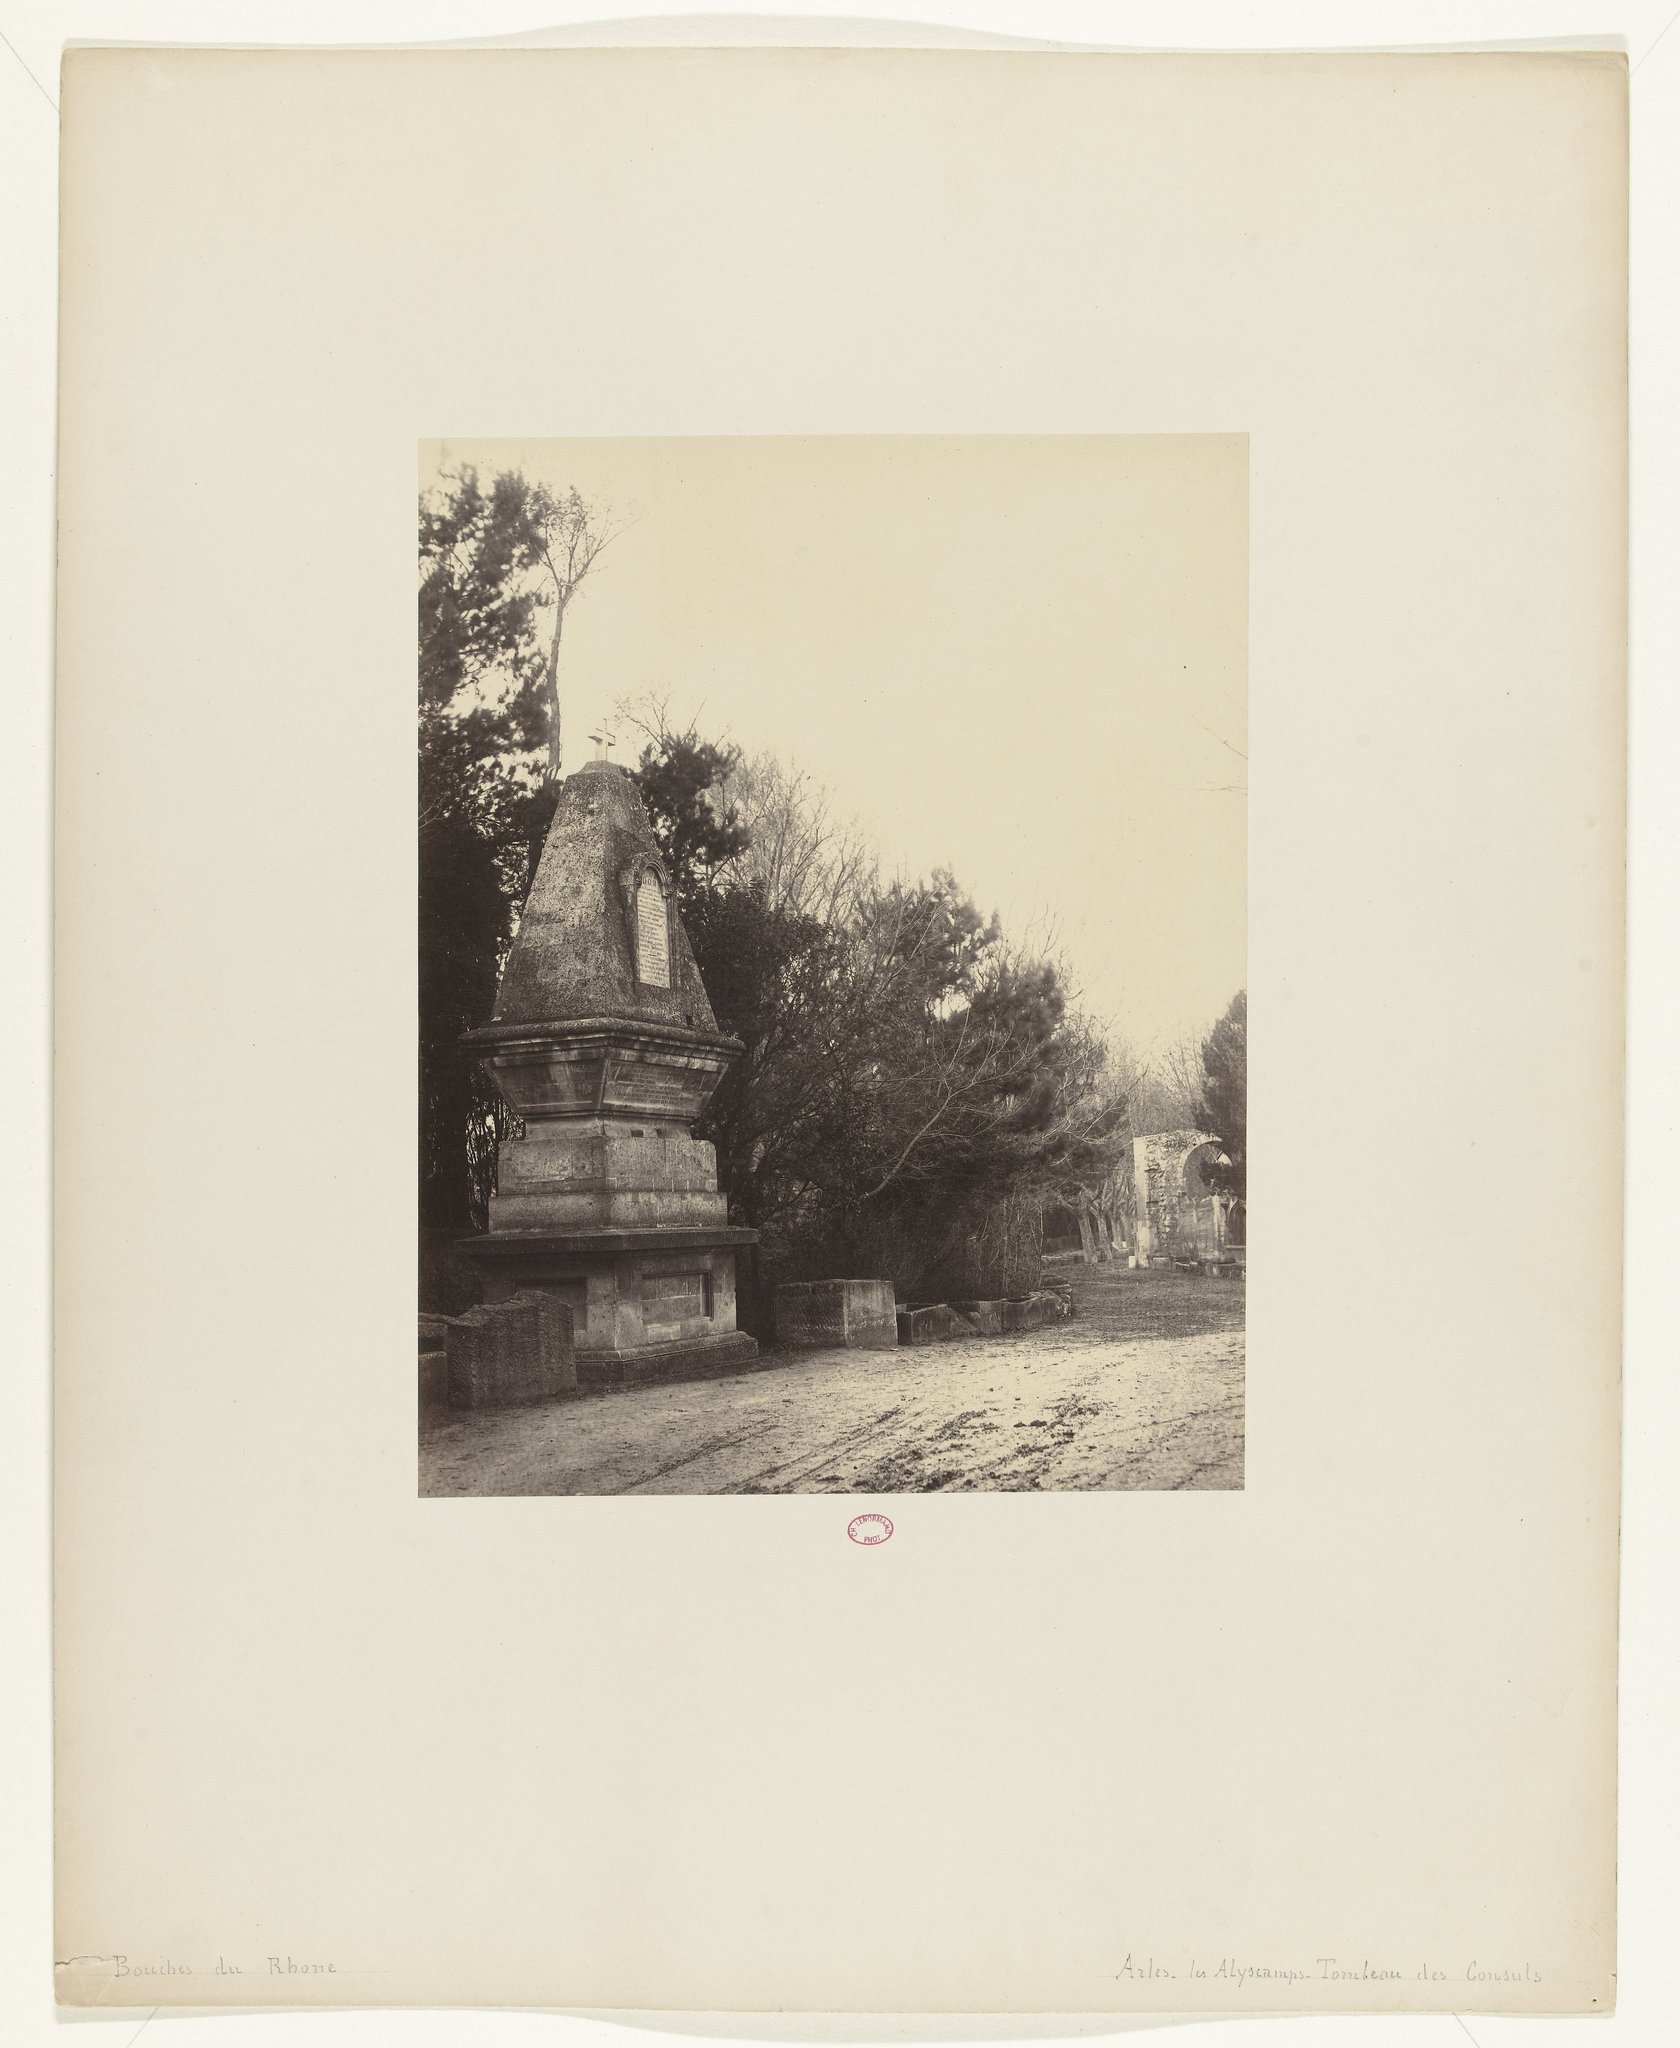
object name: photograph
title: Grafmonument van consul op begraafplaats Alyscamp te Arles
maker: charles lenormand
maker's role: fotograaf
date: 1875-1885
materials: cardboard, photographic support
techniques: albumen print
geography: france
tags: churchyard, cemetery, grave-building, monumental tomb